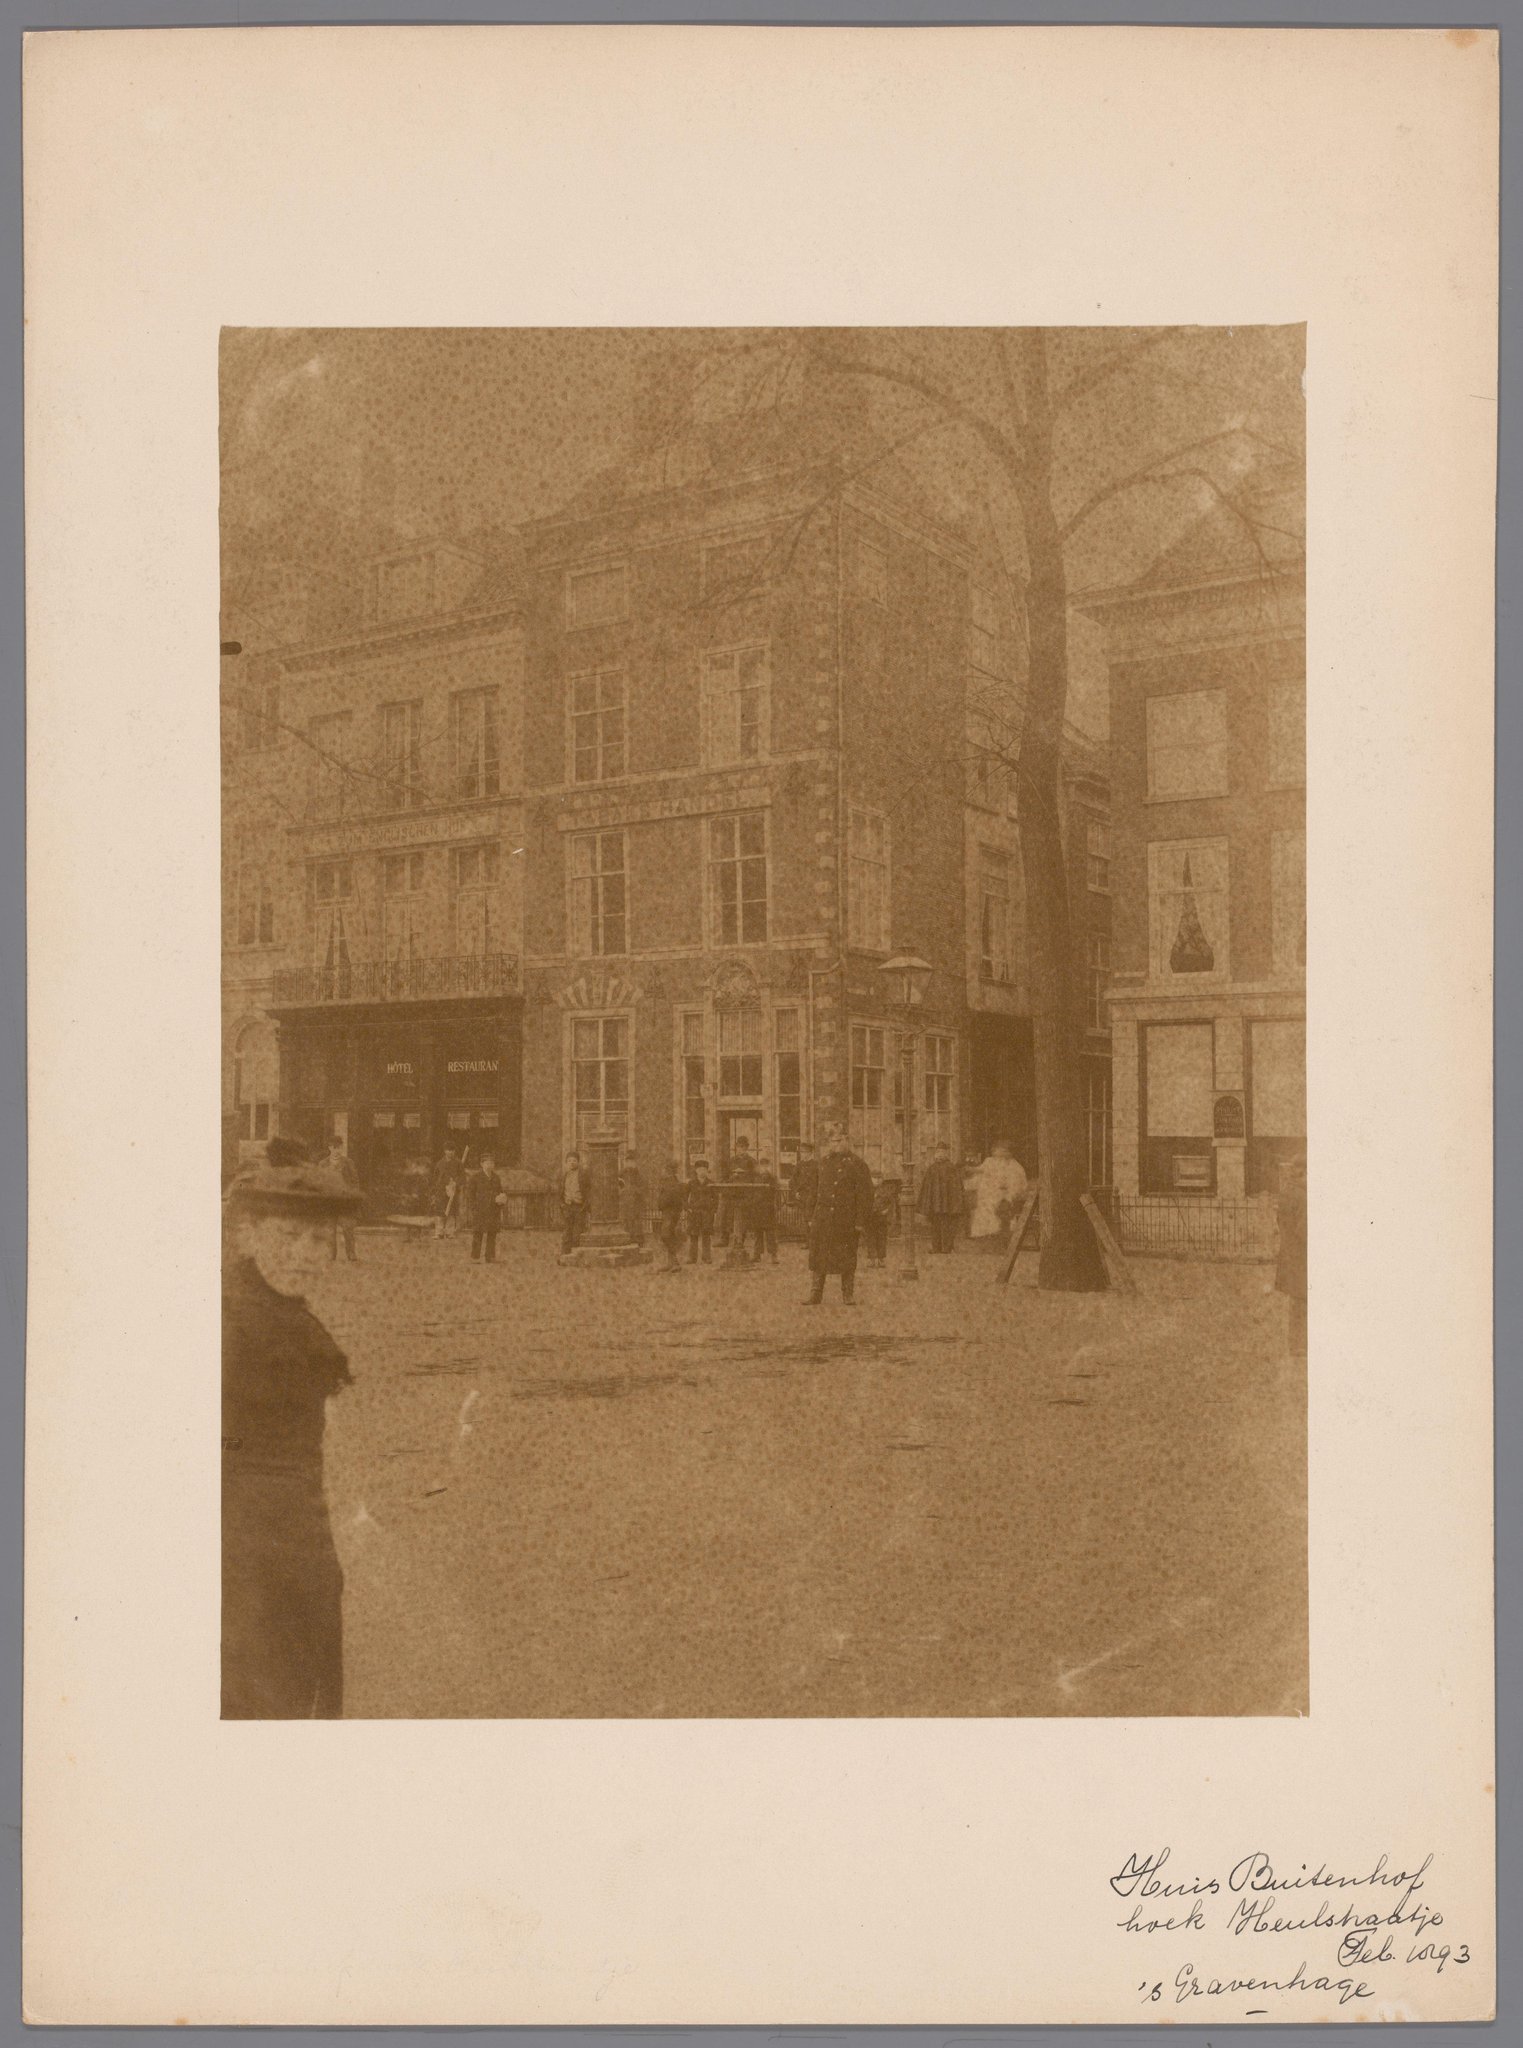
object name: photograph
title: Gezicht op een huis op het Buitenhof te Den Haag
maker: anoniem (monumentenzorg)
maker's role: fotograaf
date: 1893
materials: cardboard, photographic support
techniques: albumen print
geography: buitenhof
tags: urban housing, public road (+ city(-scape) with figures, staffage)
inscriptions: collector's mark: ‘R:MUS.’ Lugt 2228, annotation: ‘'s Gravenhage (Z.H.)/ Huis Buitenhof hoek Heulstraatje/ feb 1893’, annotation: ‘Huis Buitenhof hoek Heulstraatje/ Feb. 1893/ 's Gravenhage’